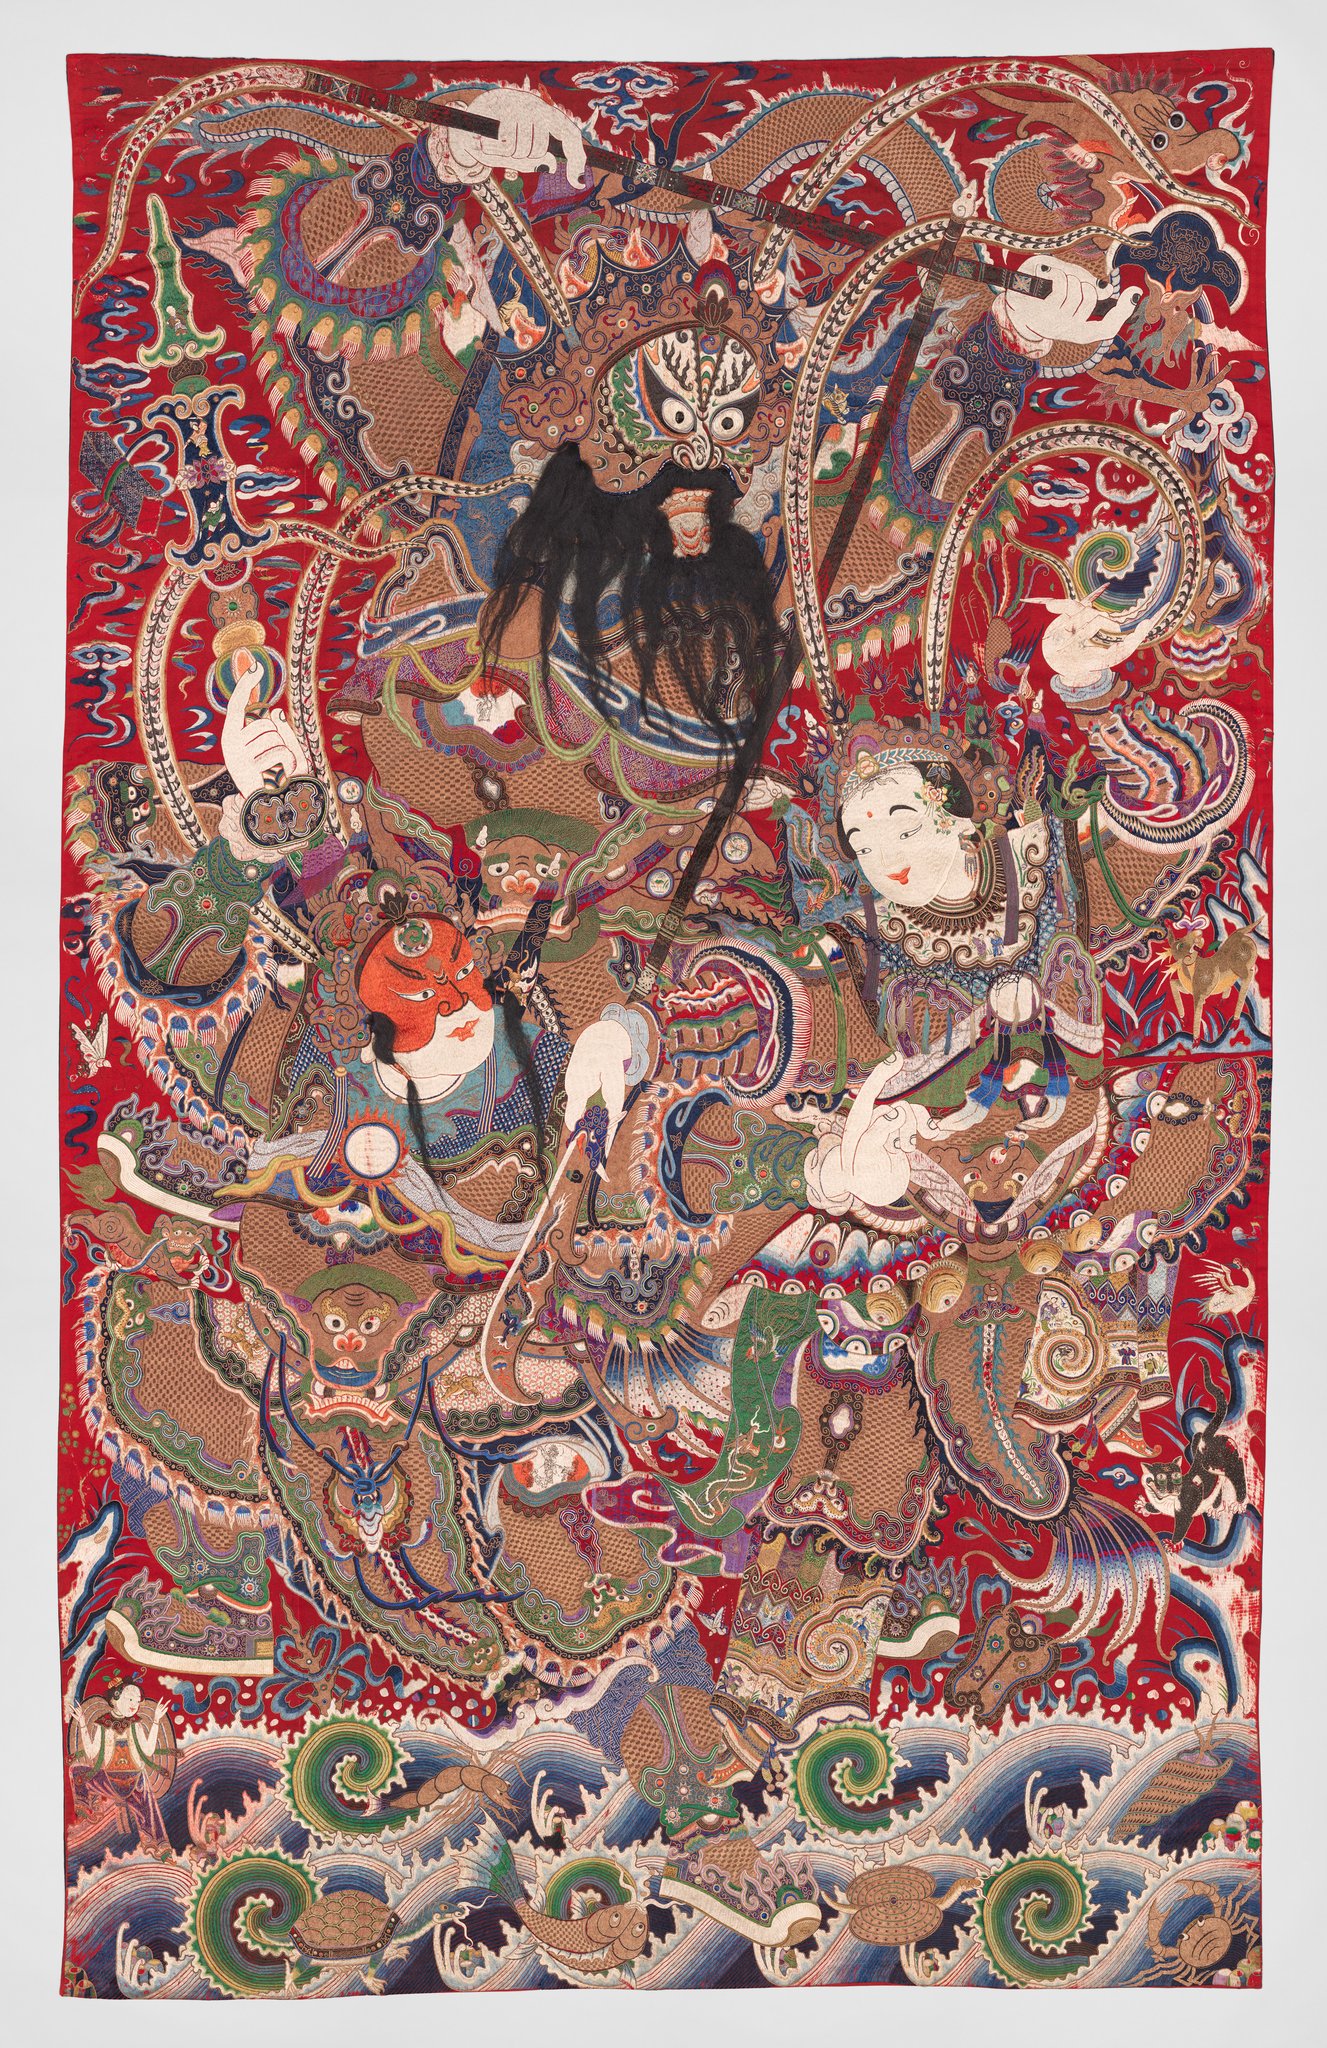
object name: hanging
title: Wall hanging with scene from an opera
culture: chinese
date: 1801-1900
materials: fiber, metal thread, silk, wool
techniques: embroidery, weave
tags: battles,men